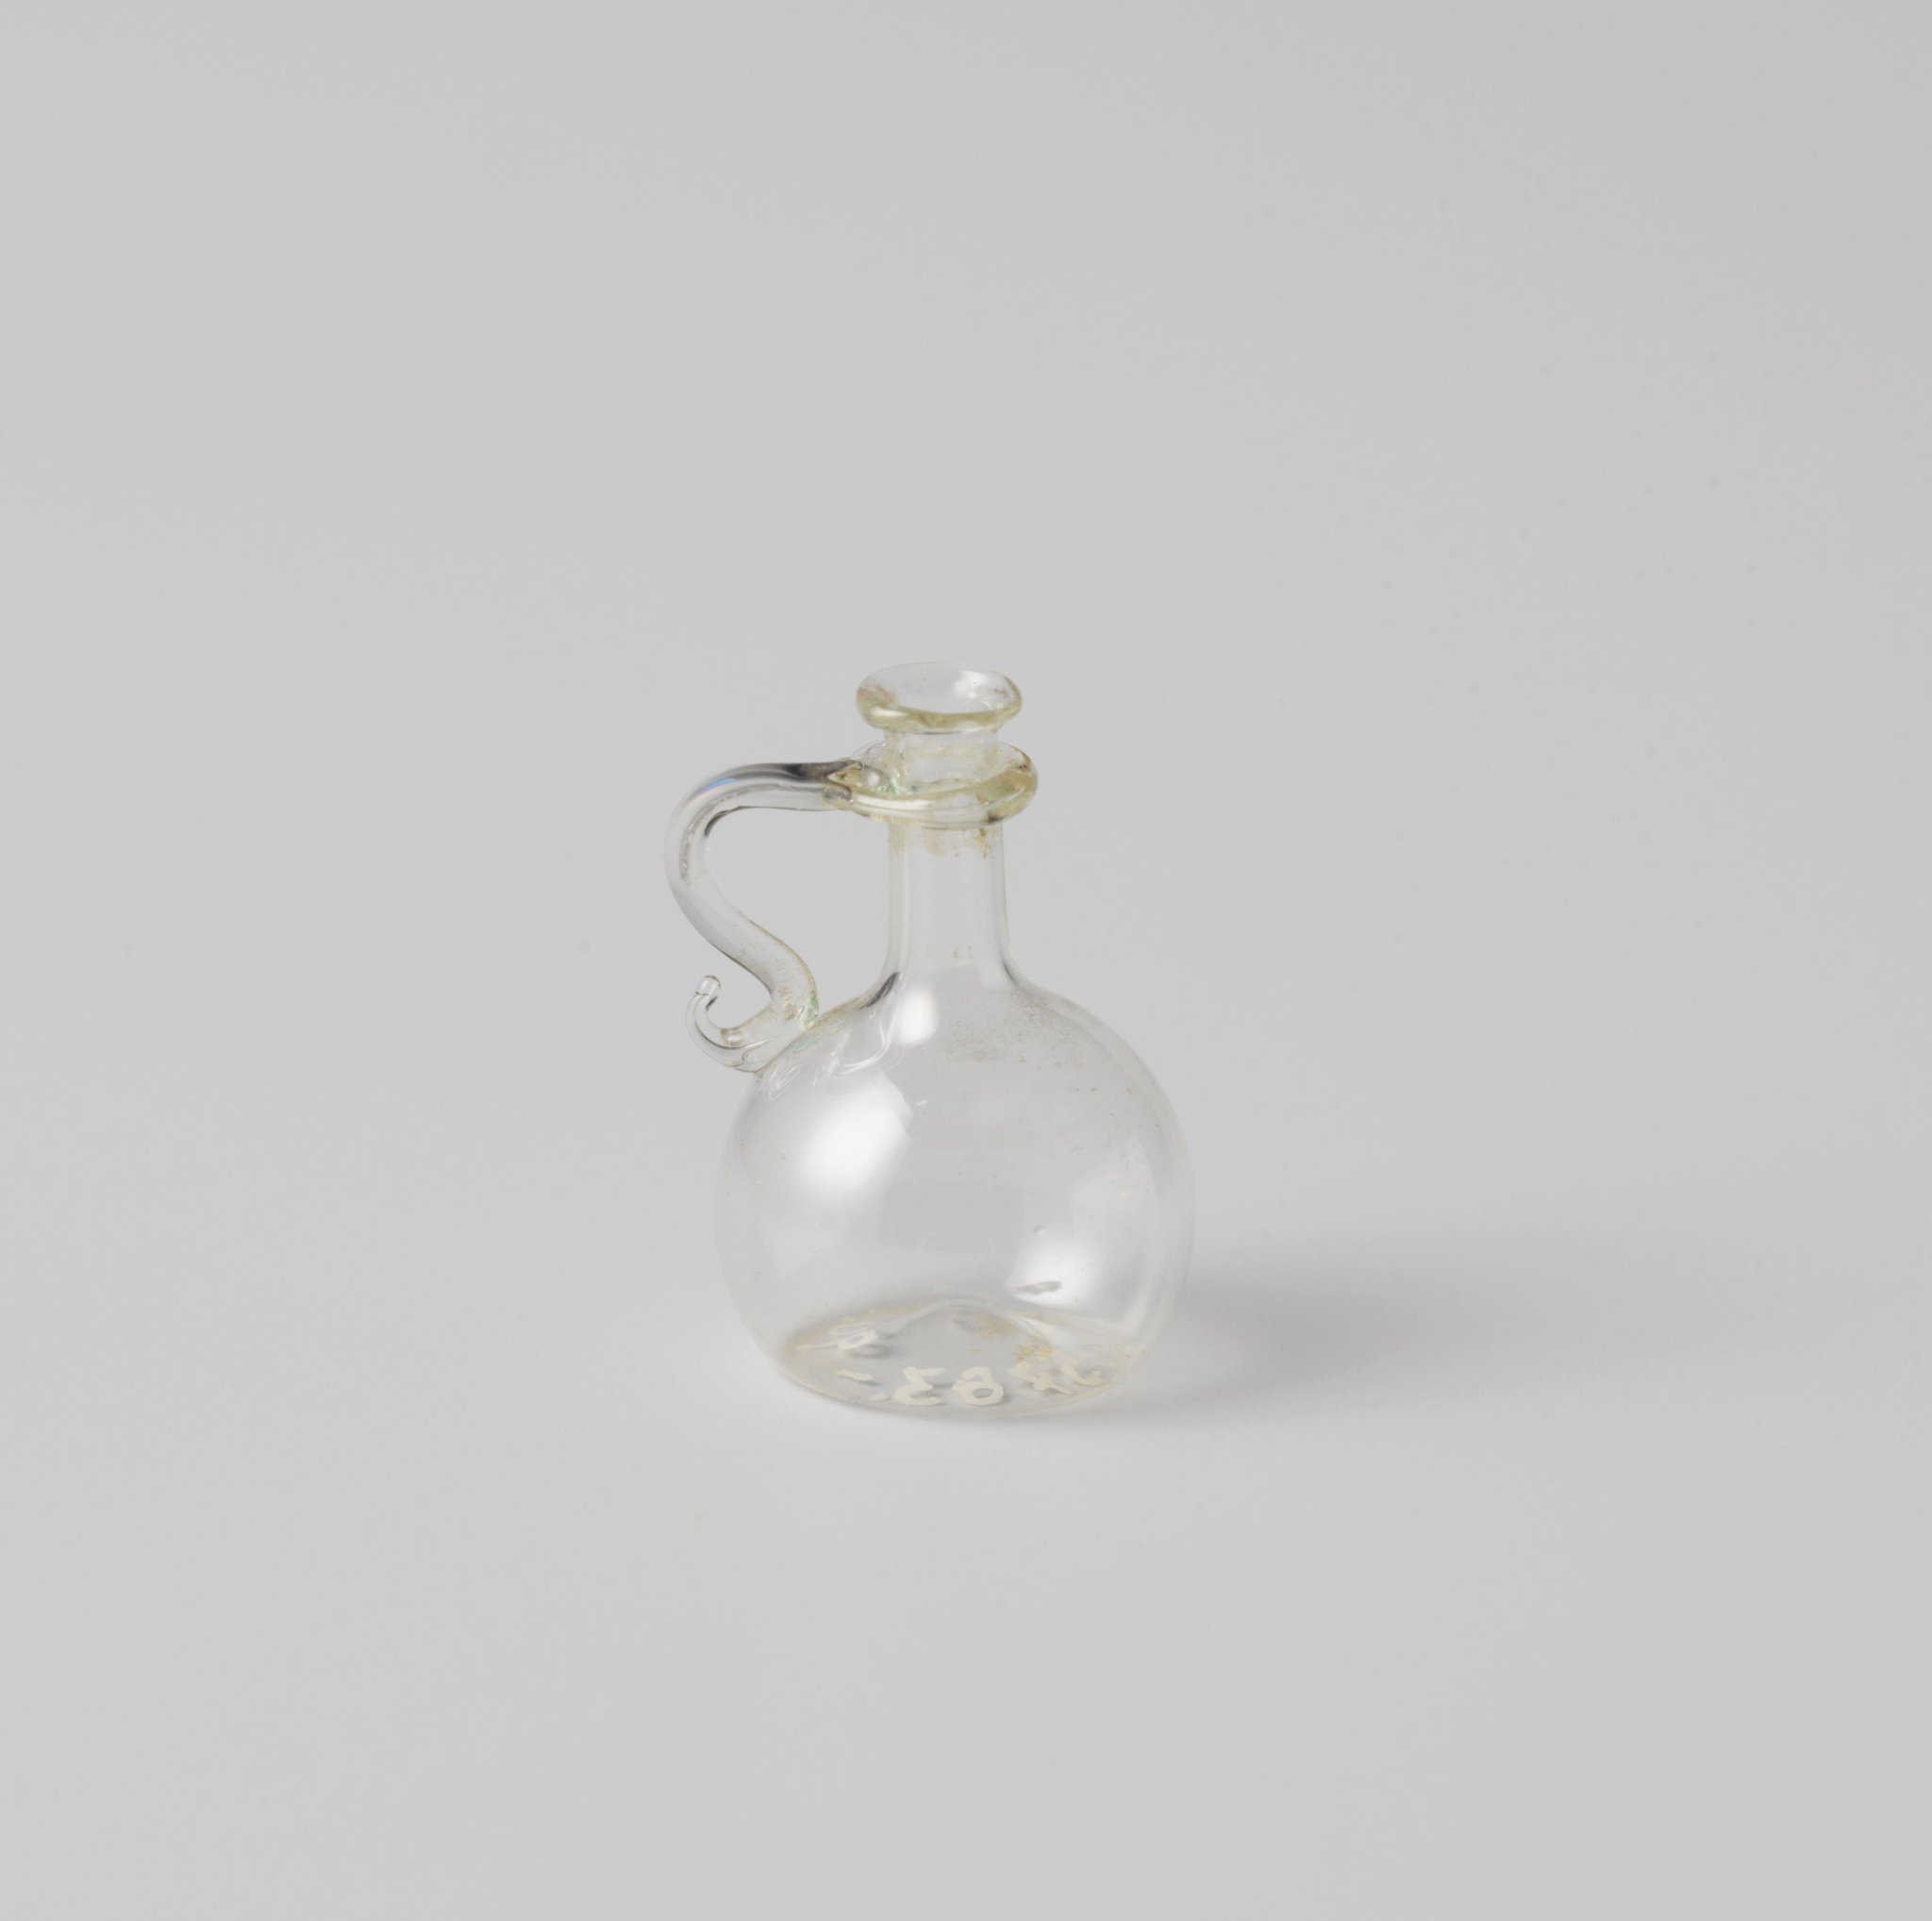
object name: miniature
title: Karaf met bolvormig lichaam met ingestoken ziel, de hals met druipring en oor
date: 1675-1699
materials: glass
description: Karaf van helder kleurloos glas, bolvormig lichaam met ingestokenziel, rechte hals met druipring, doorlopend in oor eindigend in krul.